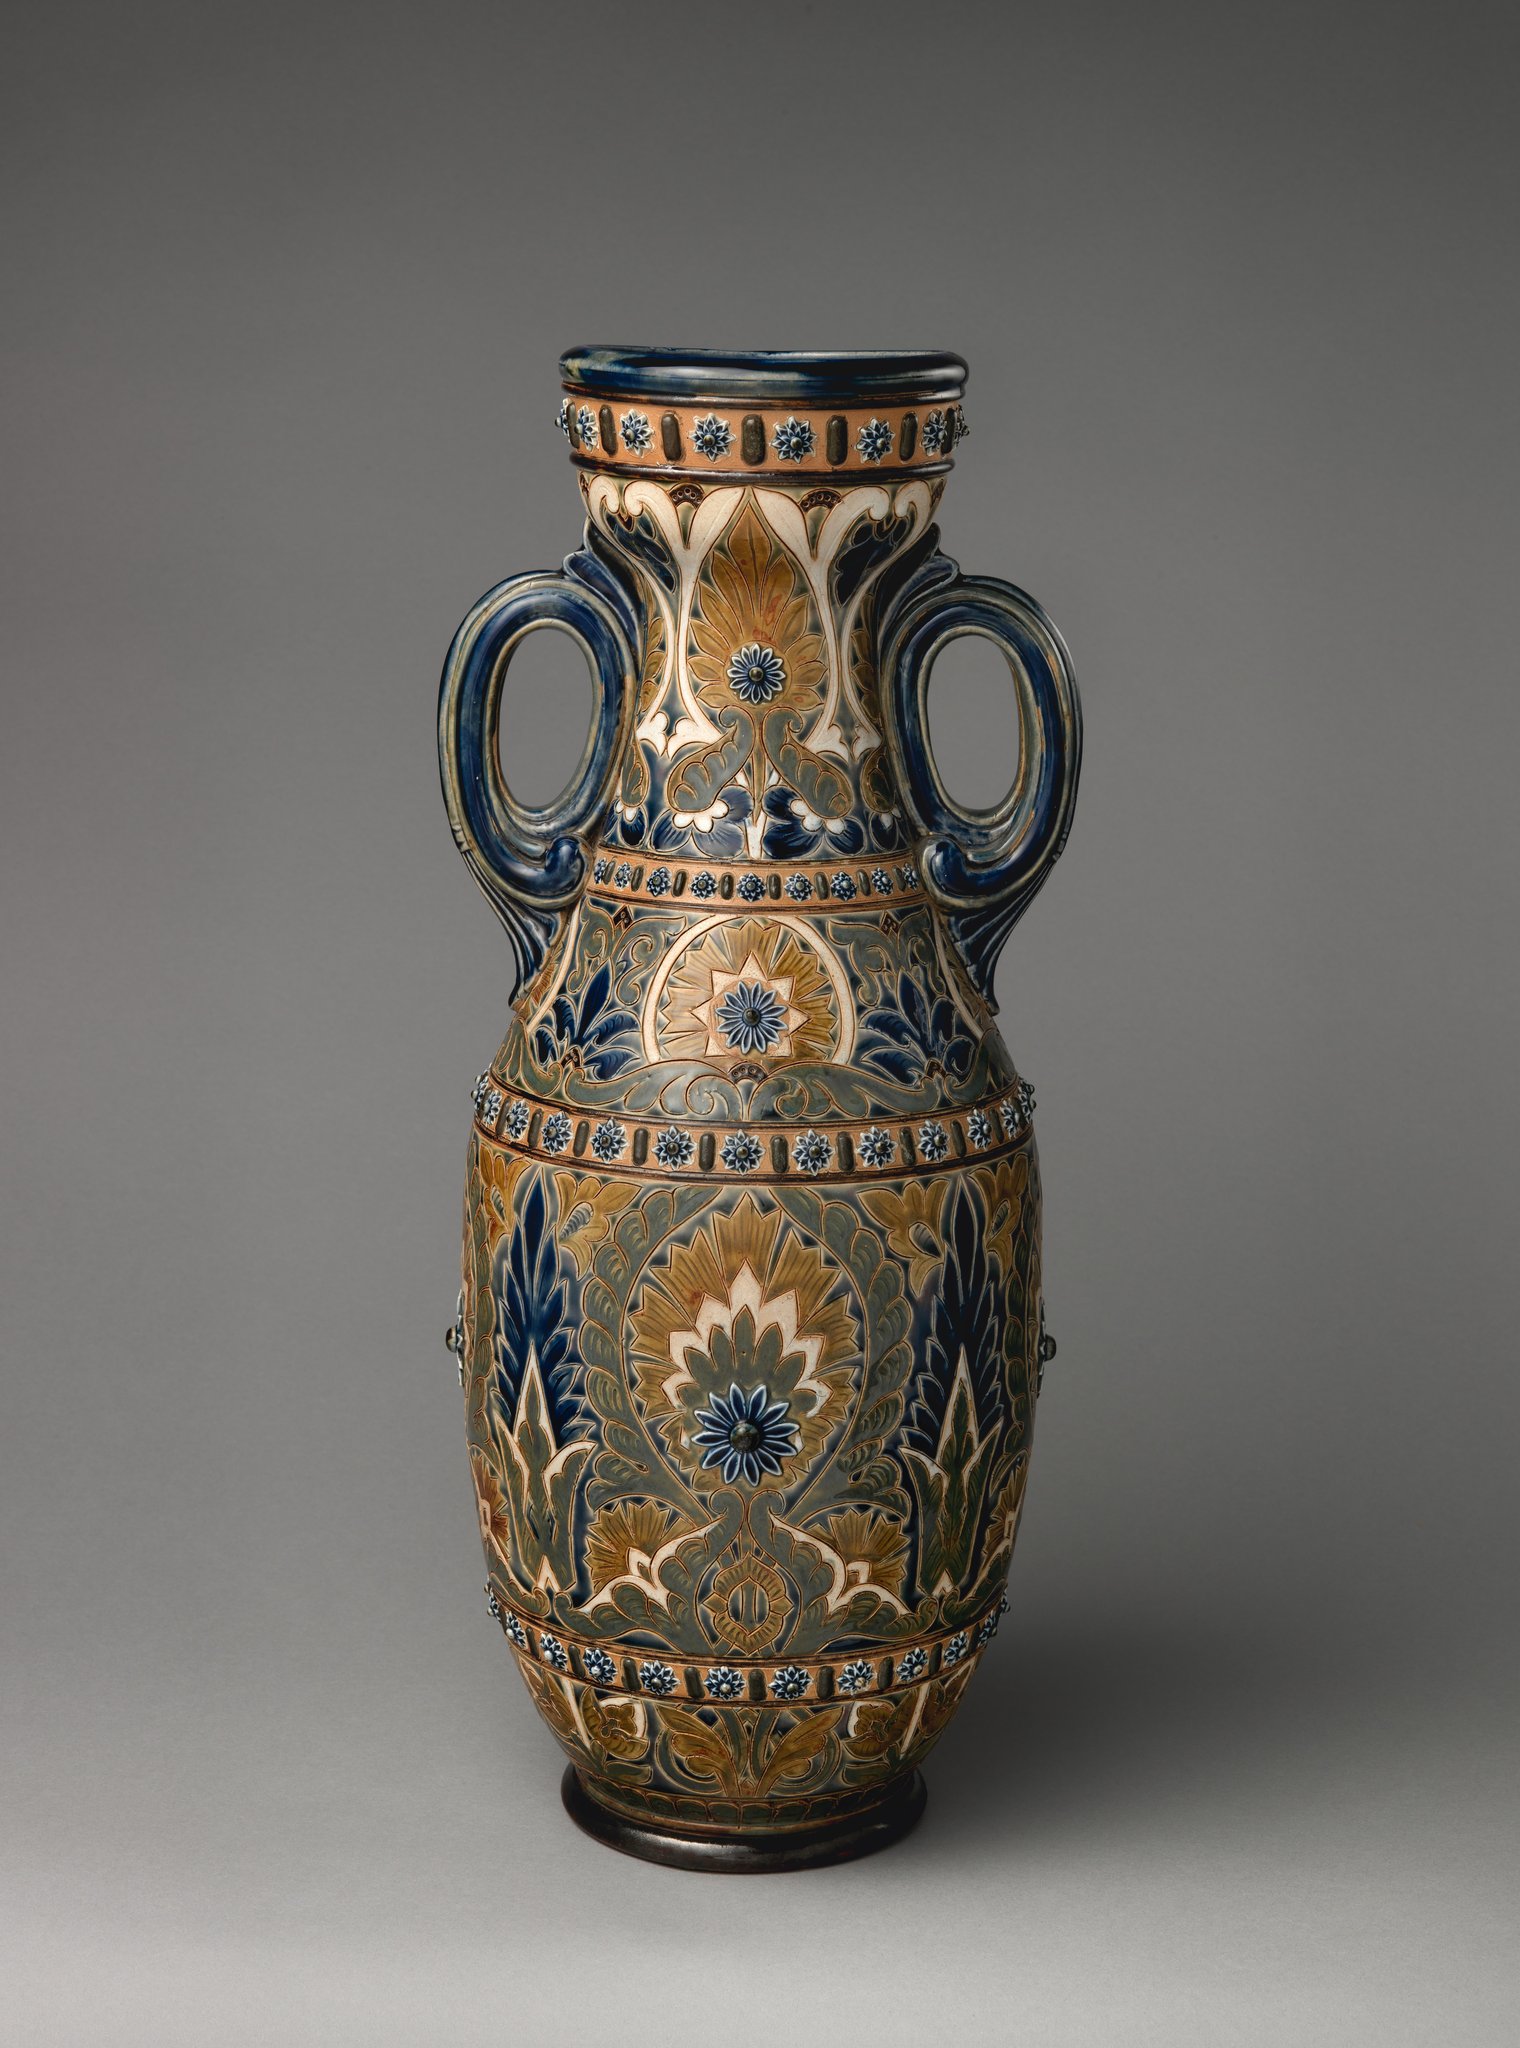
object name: vase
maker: frank a. butler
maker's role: maker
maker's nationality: british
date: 1879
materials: stoneware